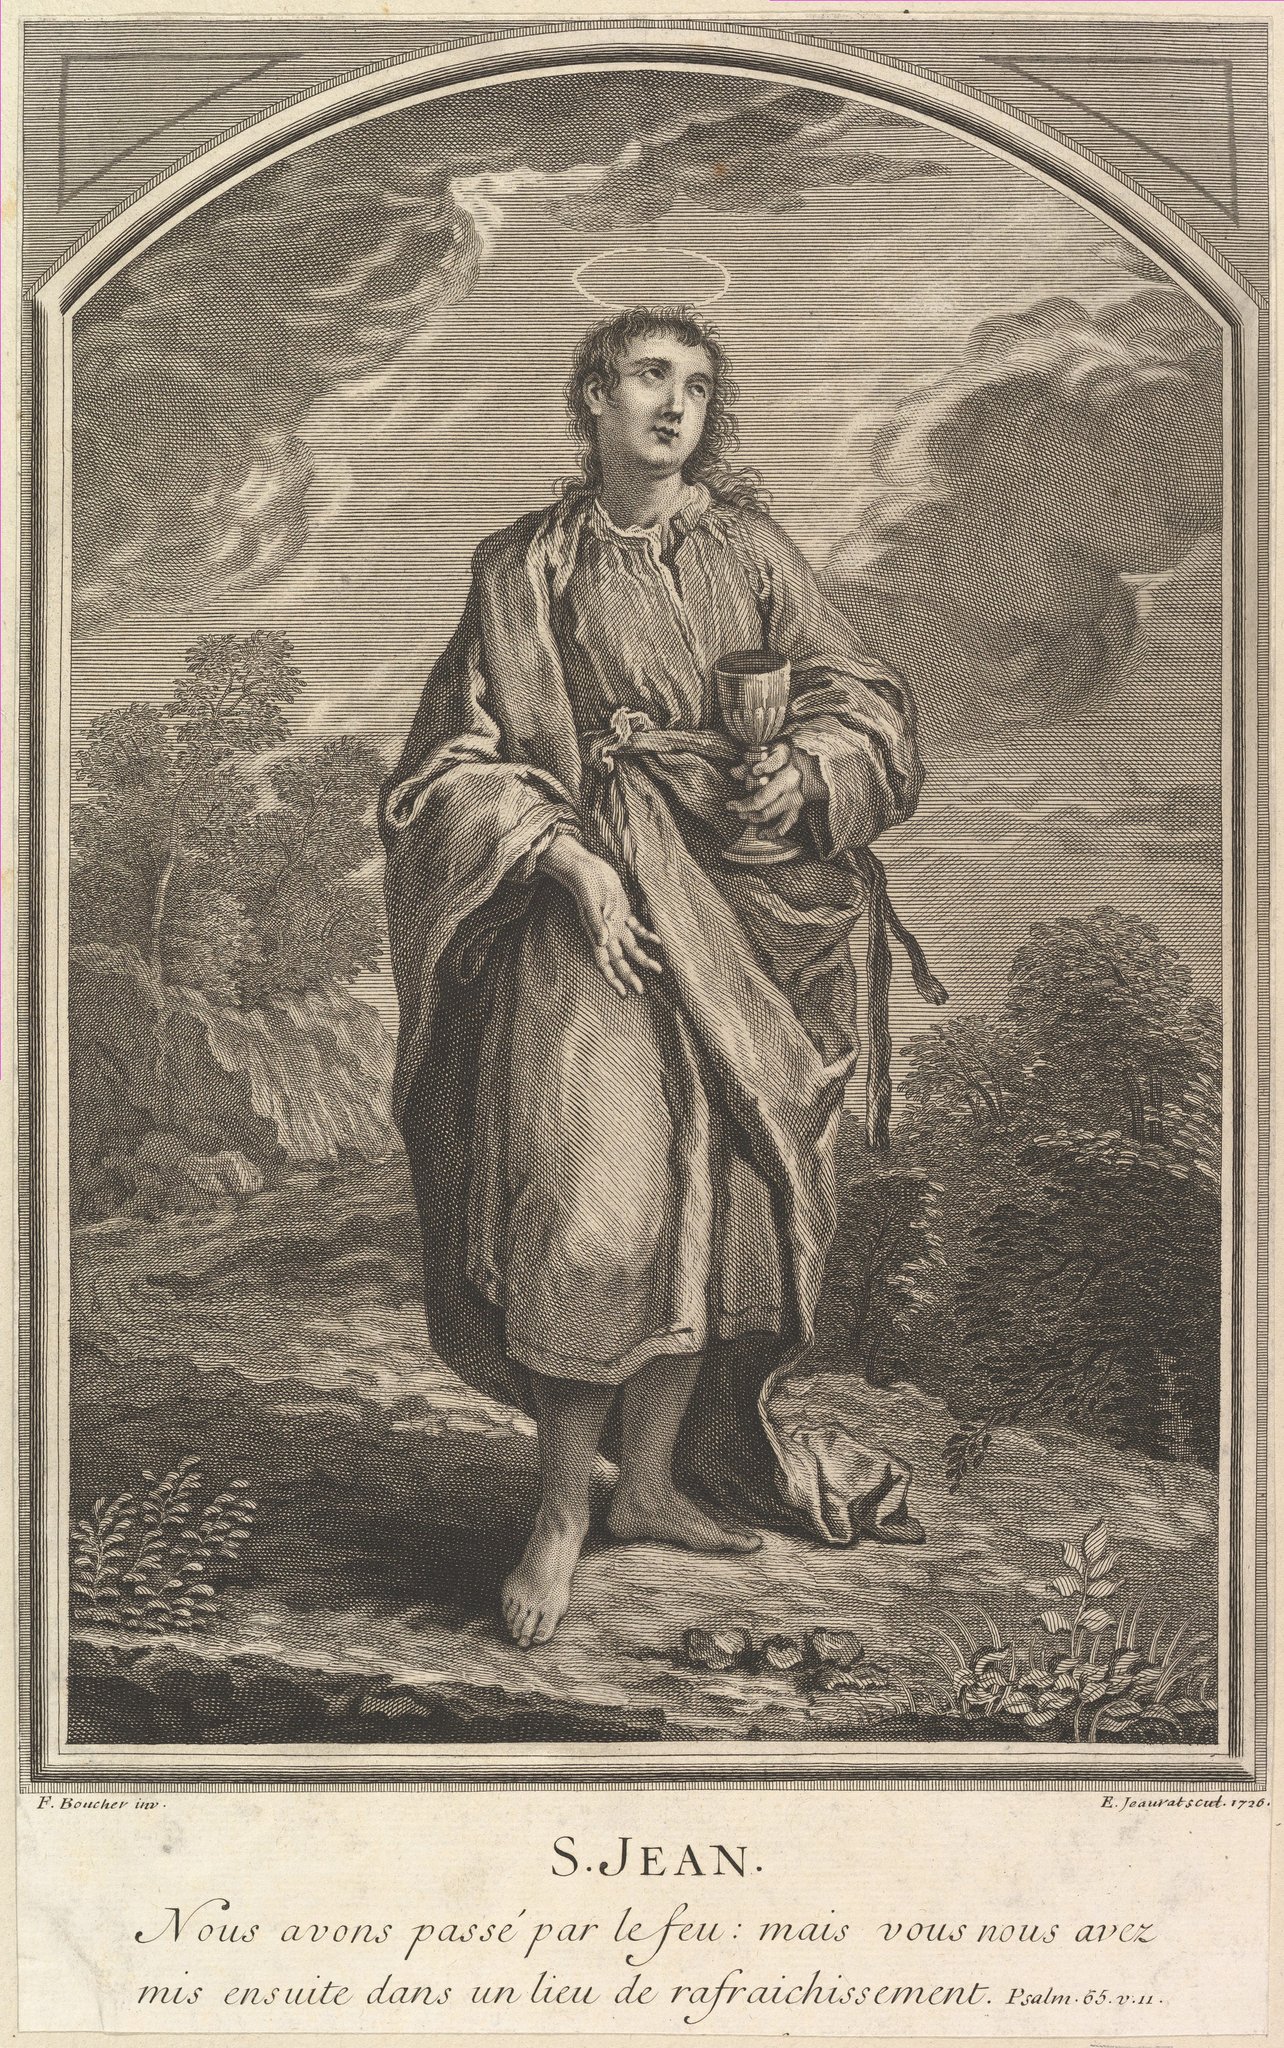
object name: print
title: Saint Jean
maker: edmé jeaurat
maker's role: artist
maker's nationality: french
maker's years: 1688-1738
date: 1726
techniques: engraving, etching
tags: saints